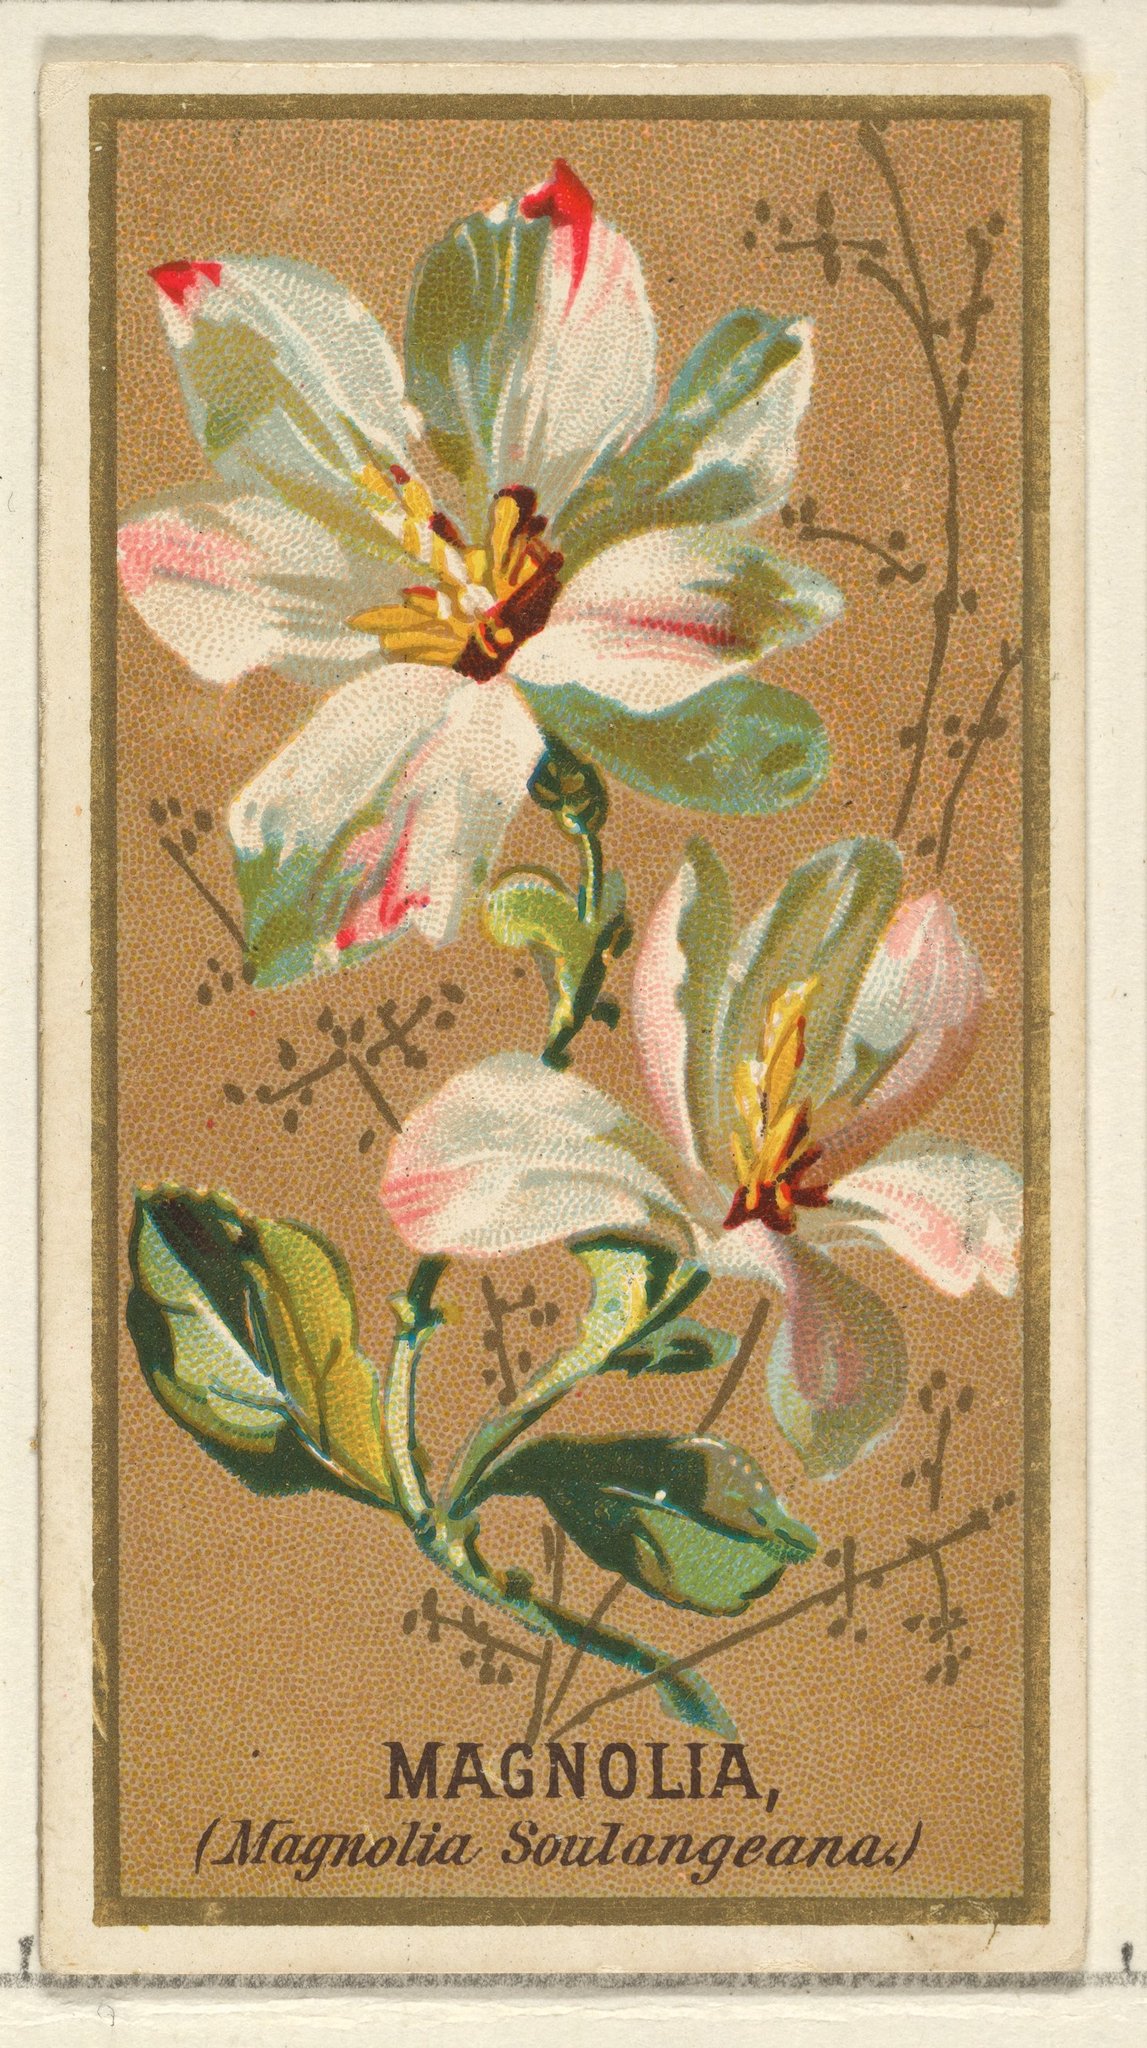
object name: print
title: Magnolia (Magnolia Soulangeana), from the Flowers series for Old Judge Cigarettes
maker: goodwin & company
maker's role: publisher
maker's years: 1850-1950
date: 1890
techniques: color lithograph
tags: flowers,leaves